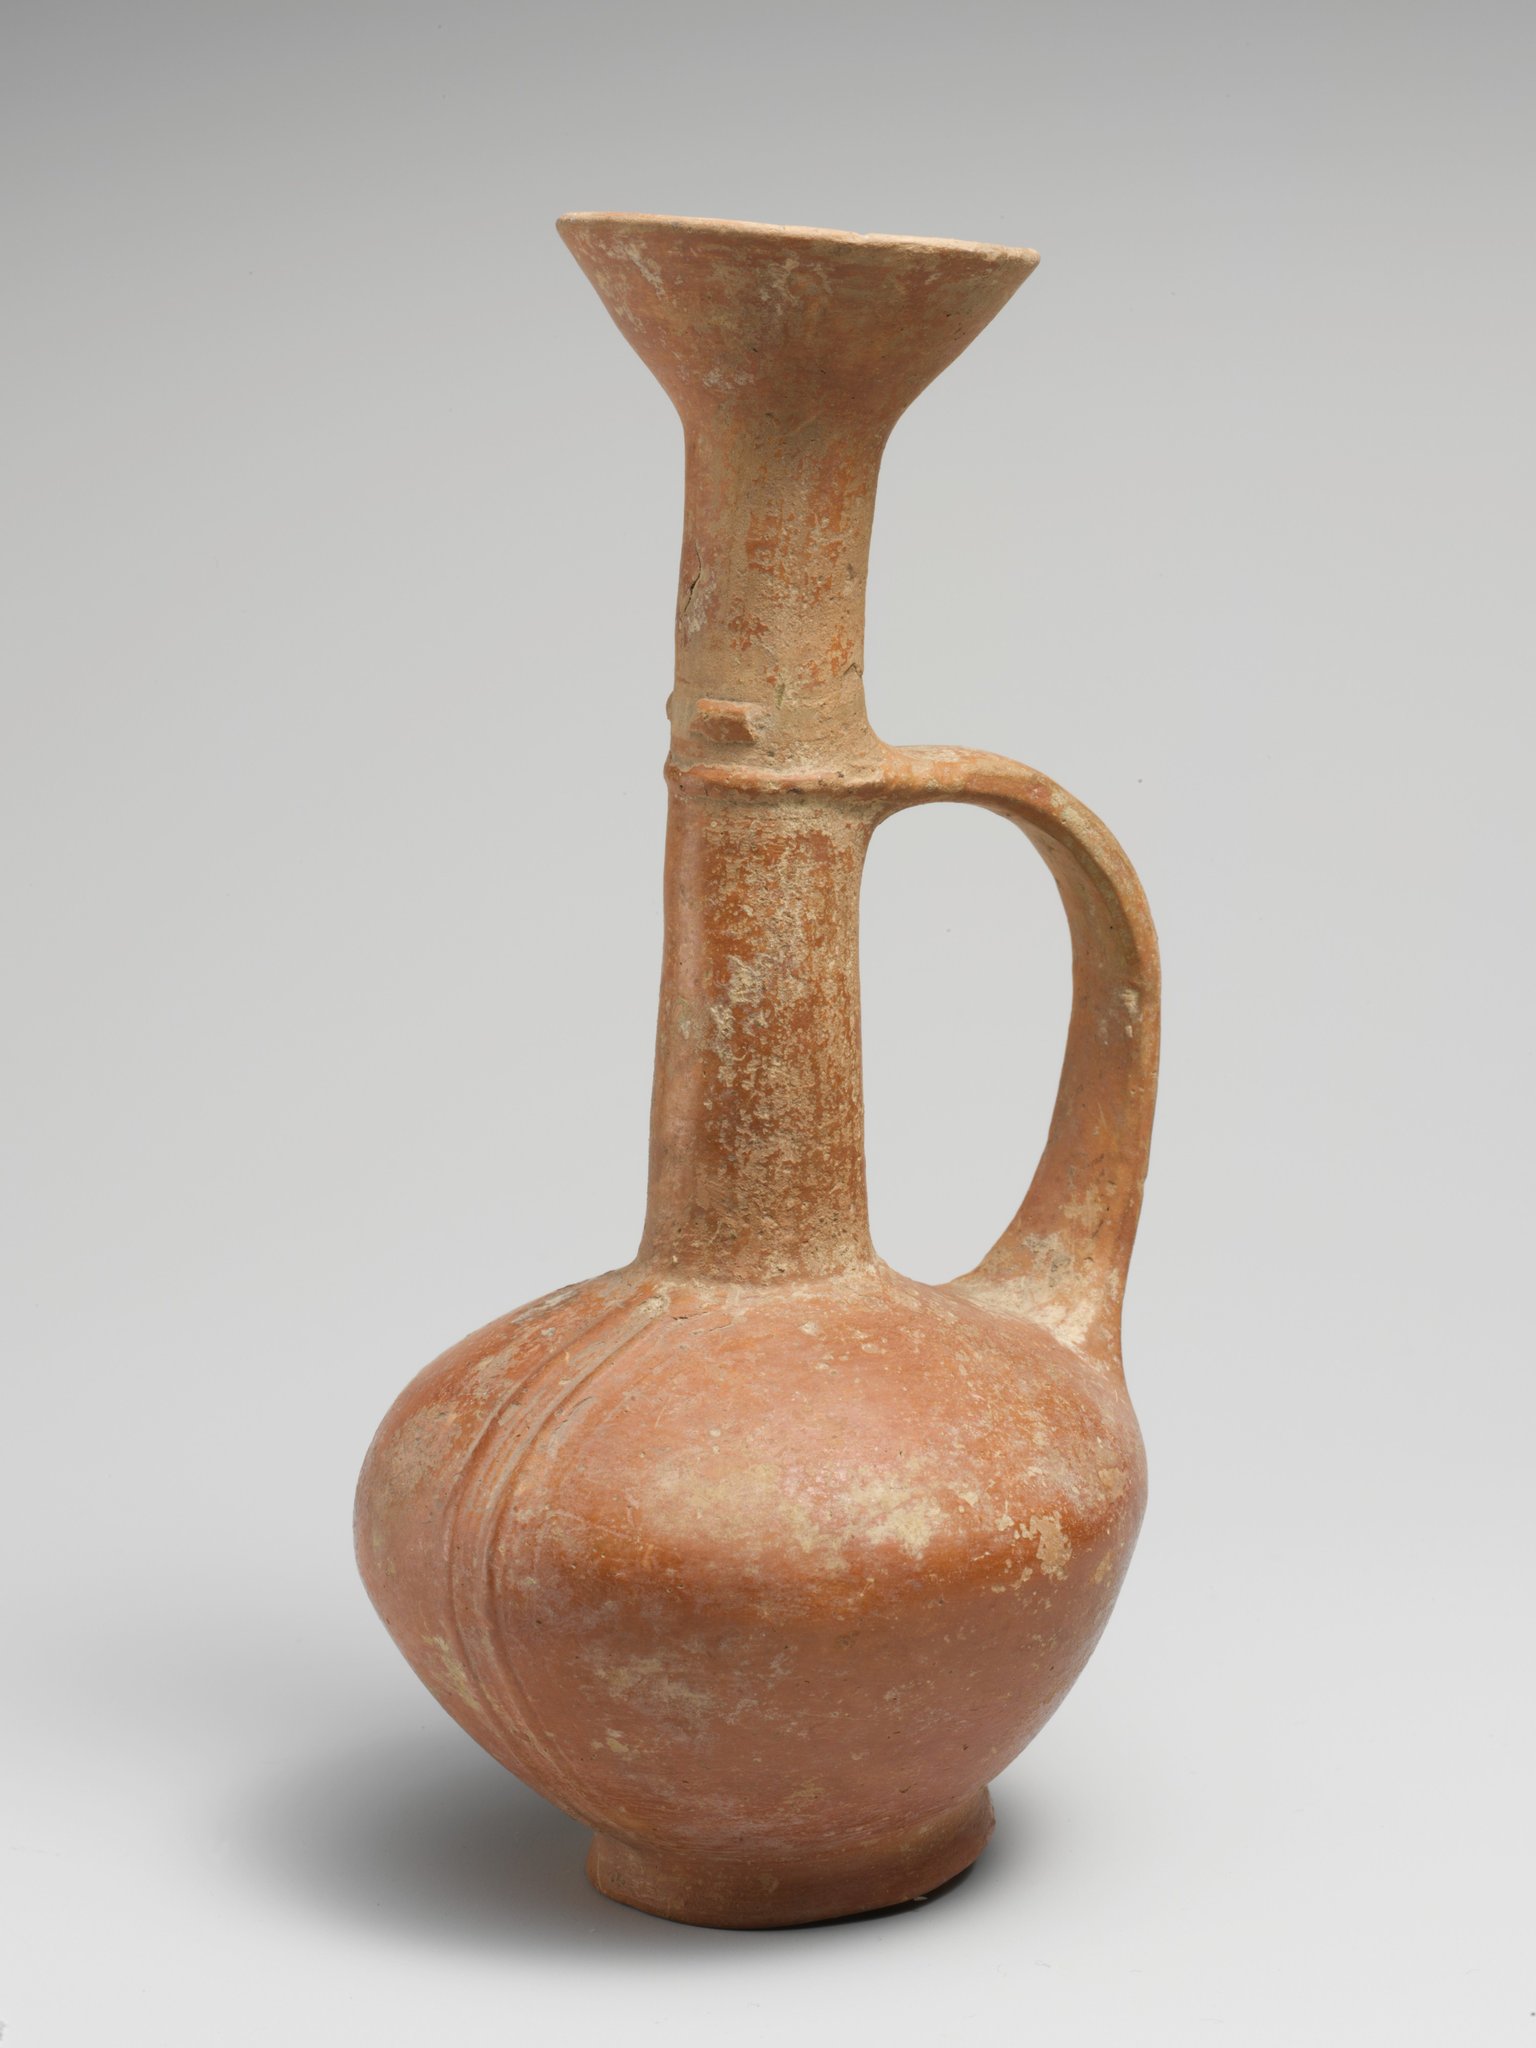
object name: jug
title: Terracotta jug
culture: cypriot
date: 1600-1450 BCE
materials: terracotta